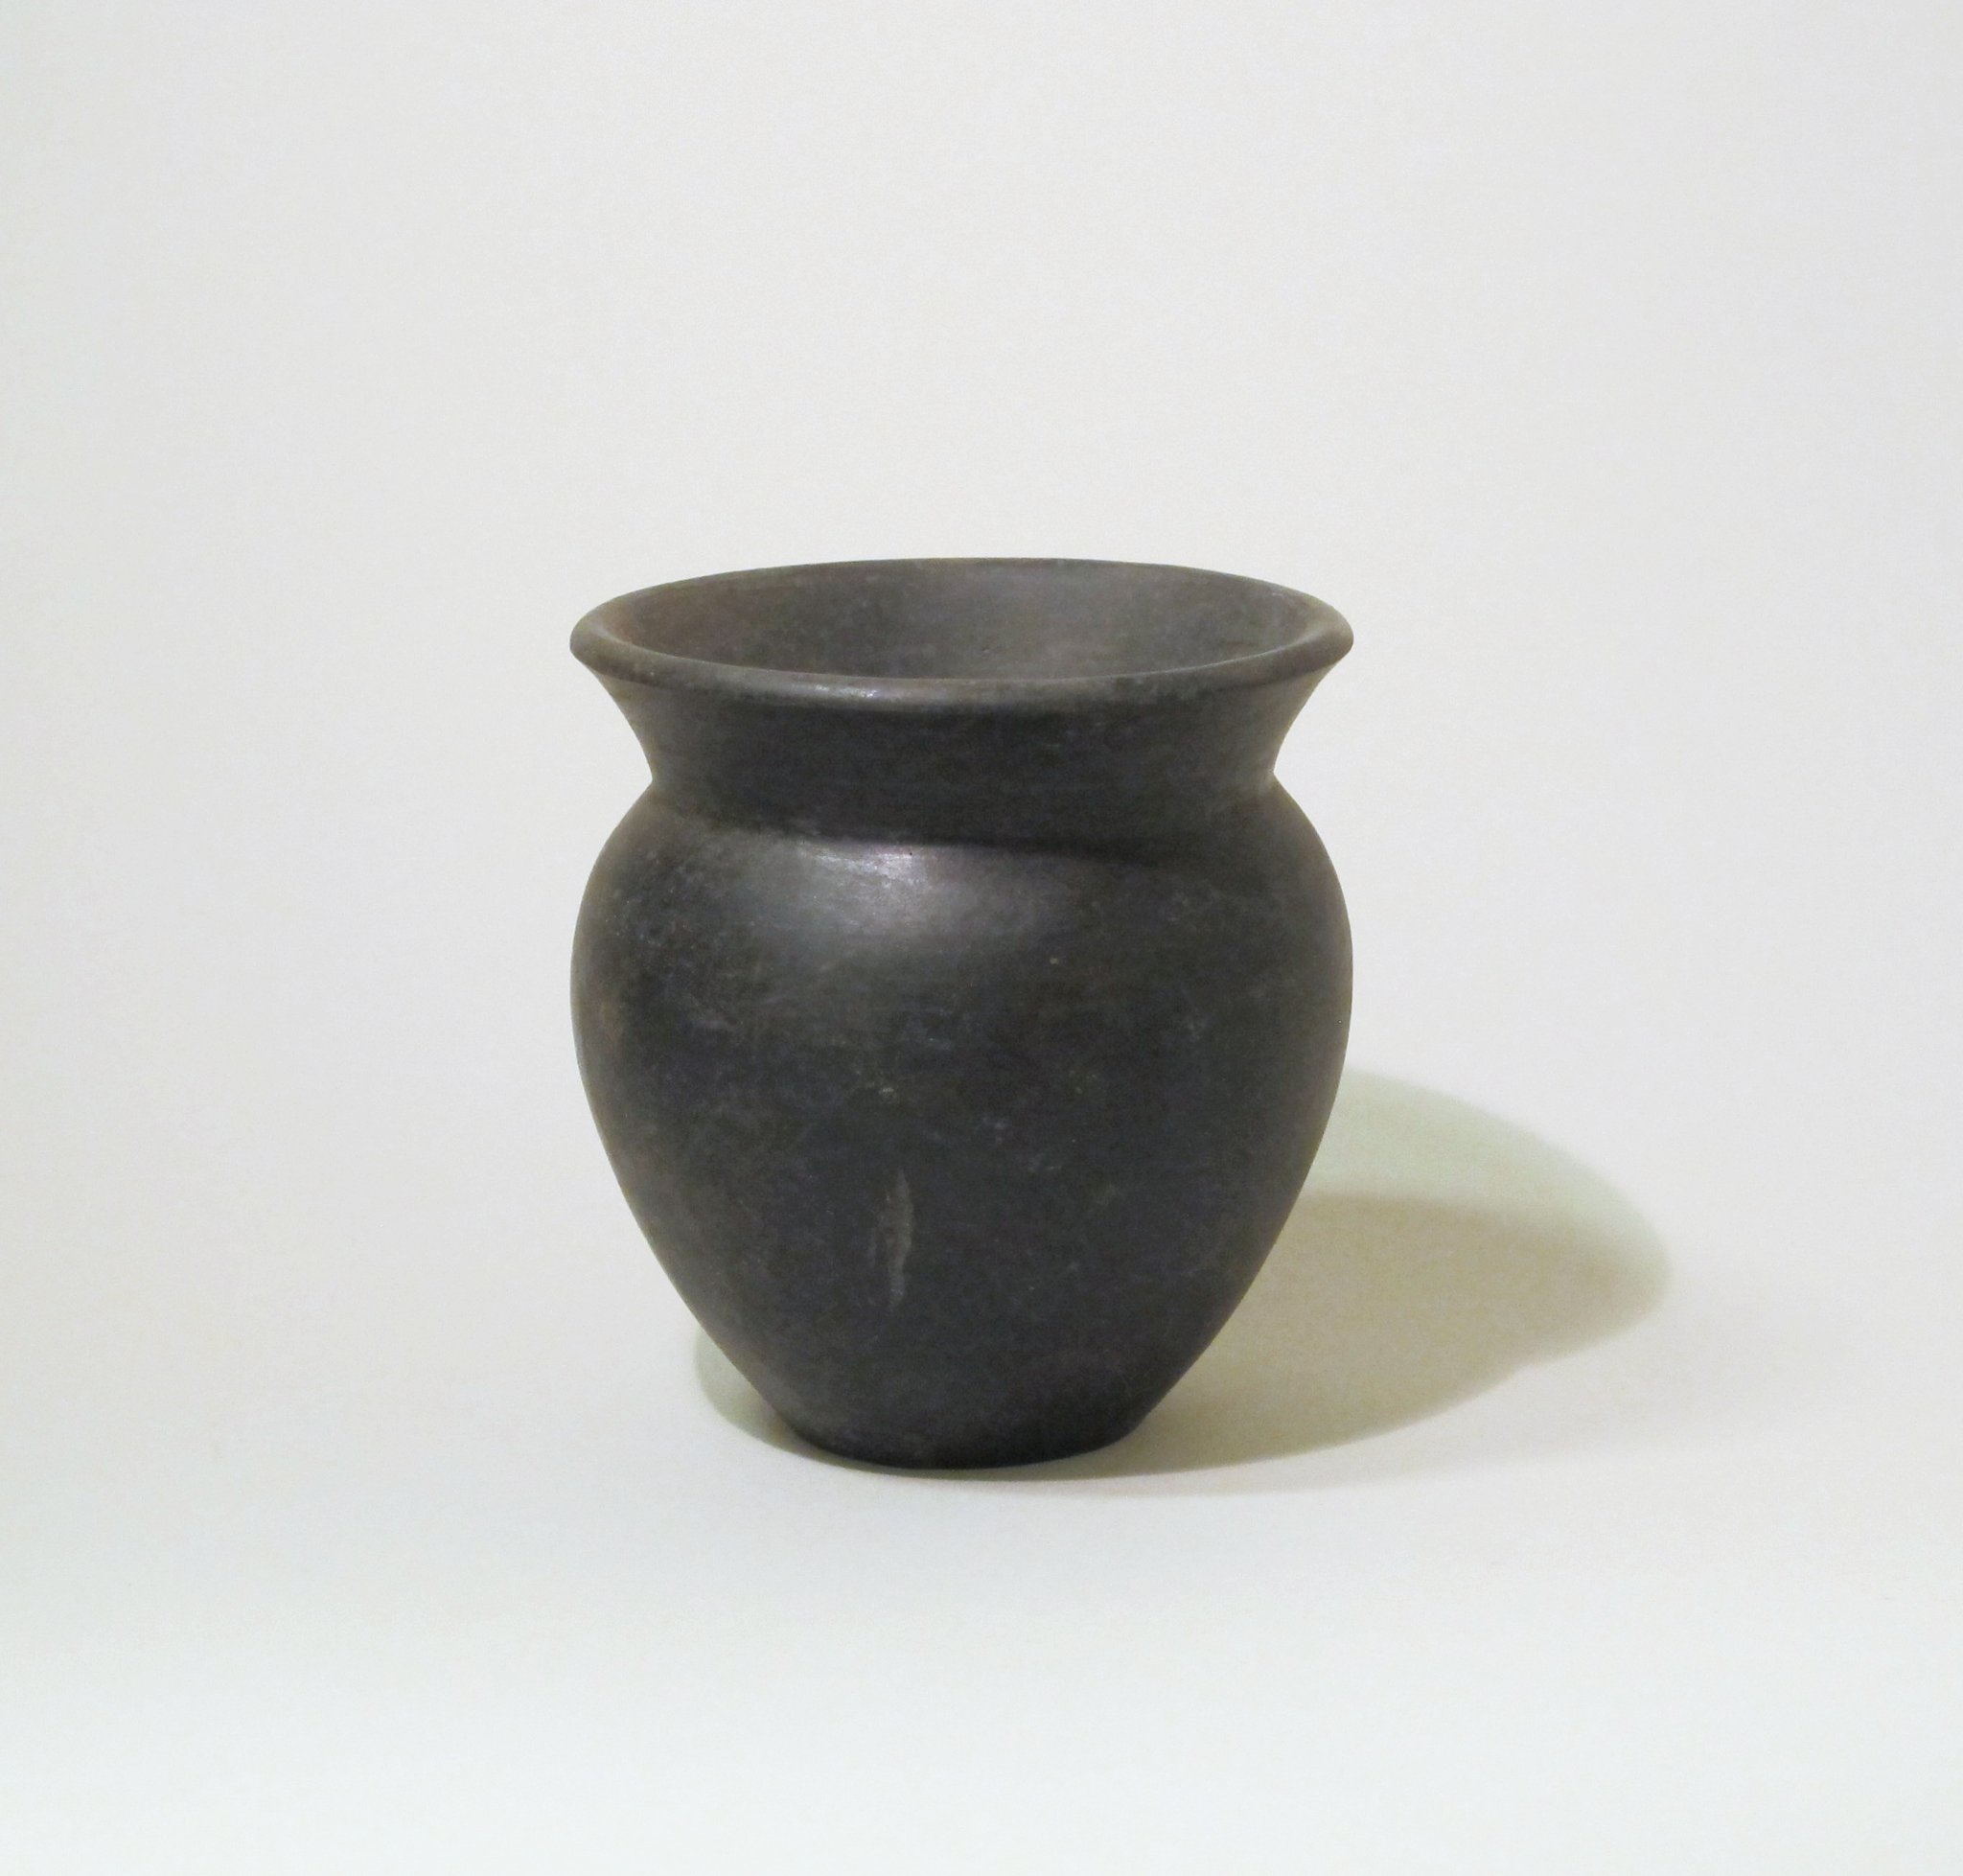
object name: focolare bowl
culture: etruscan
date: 550-501 BCE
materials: terracotta